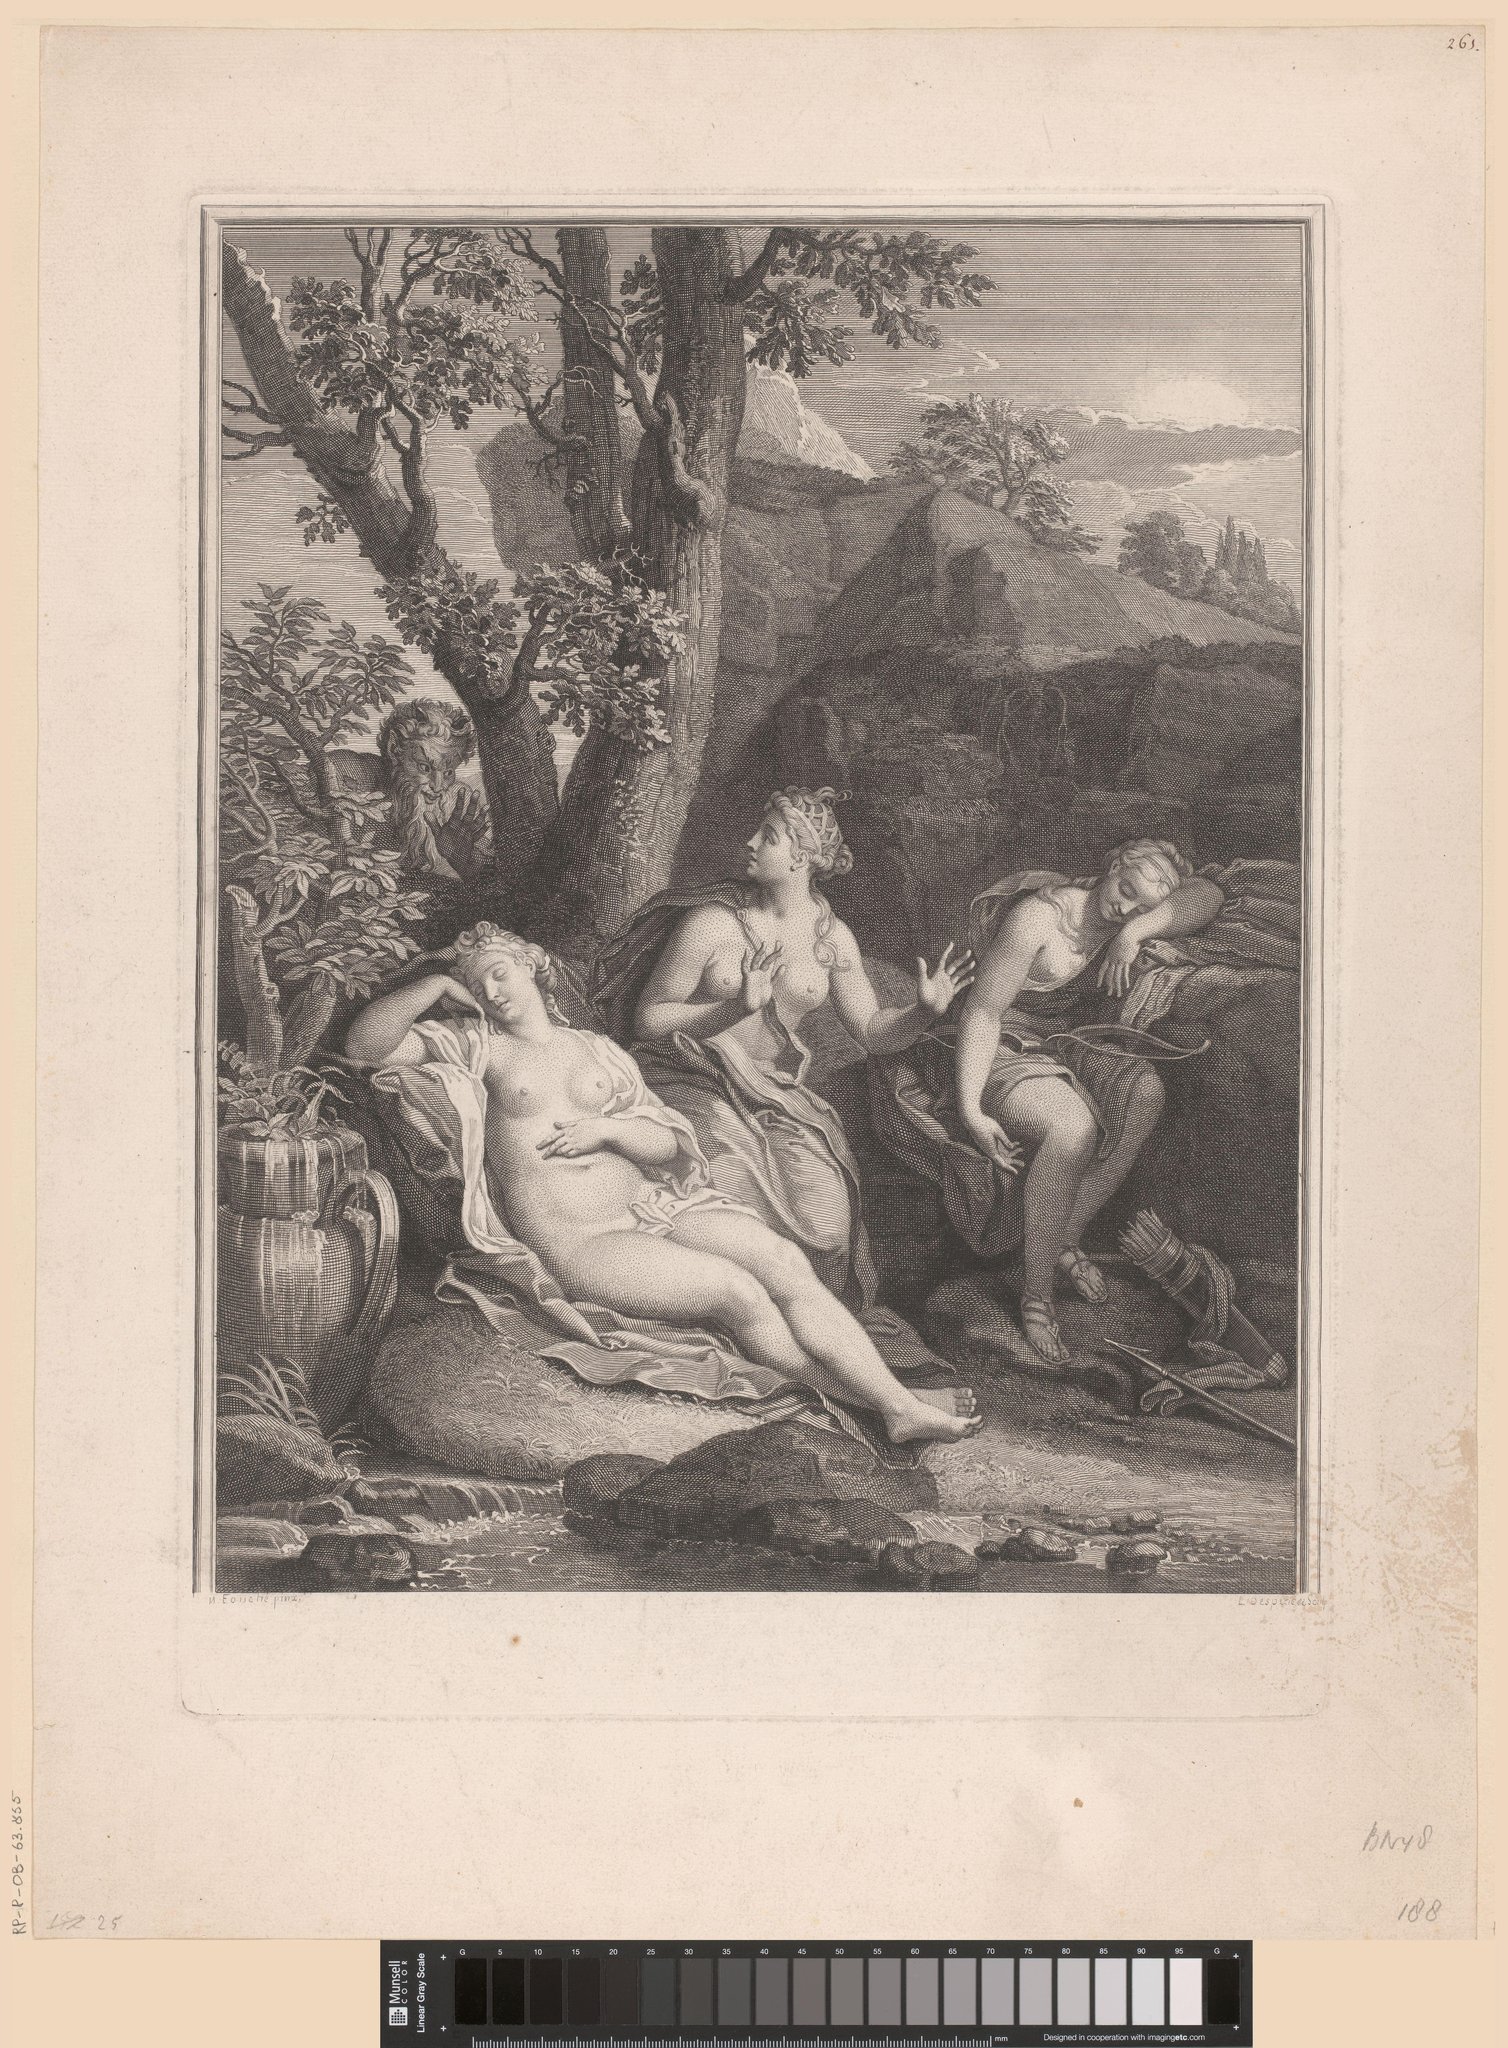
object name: print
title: Slapende Diana en haar nimfen verrast door een sater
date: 1692-1739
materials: paper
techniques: engraving, etching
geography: paris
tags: diana and her nymphs surprised by satyrs, sleeping; unconsciousness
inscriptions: collector's mark: Lugt 240, number: ‘263.’